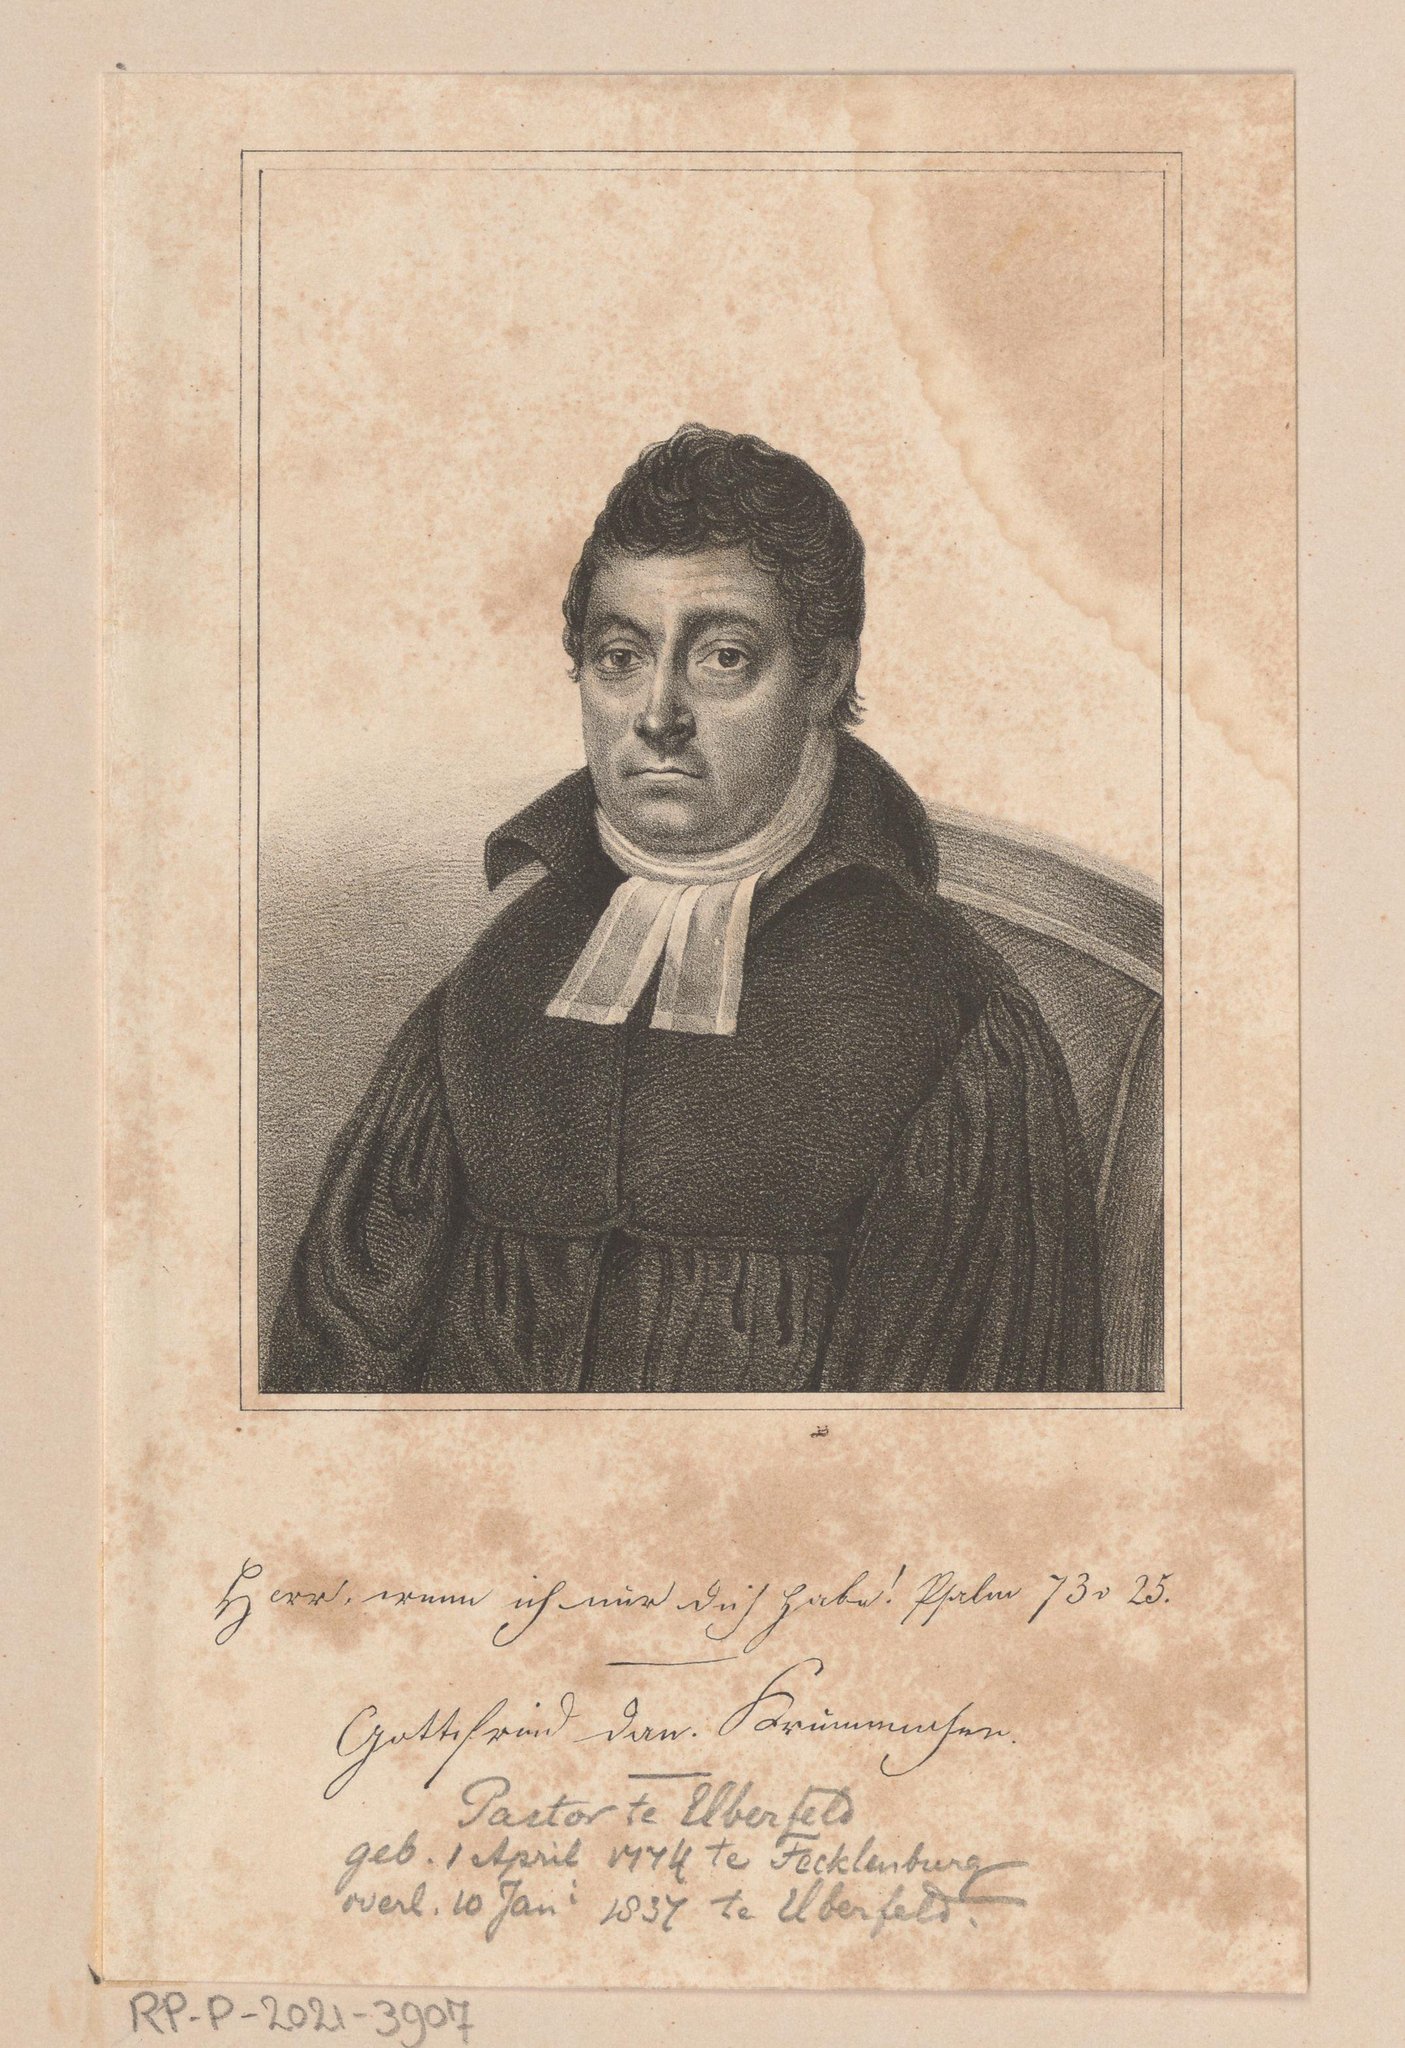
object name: print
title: Portret van Gottfried Daniel Krummacher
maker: Anonymous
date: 1794-1899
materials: paper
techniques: lithograph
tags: historical persons